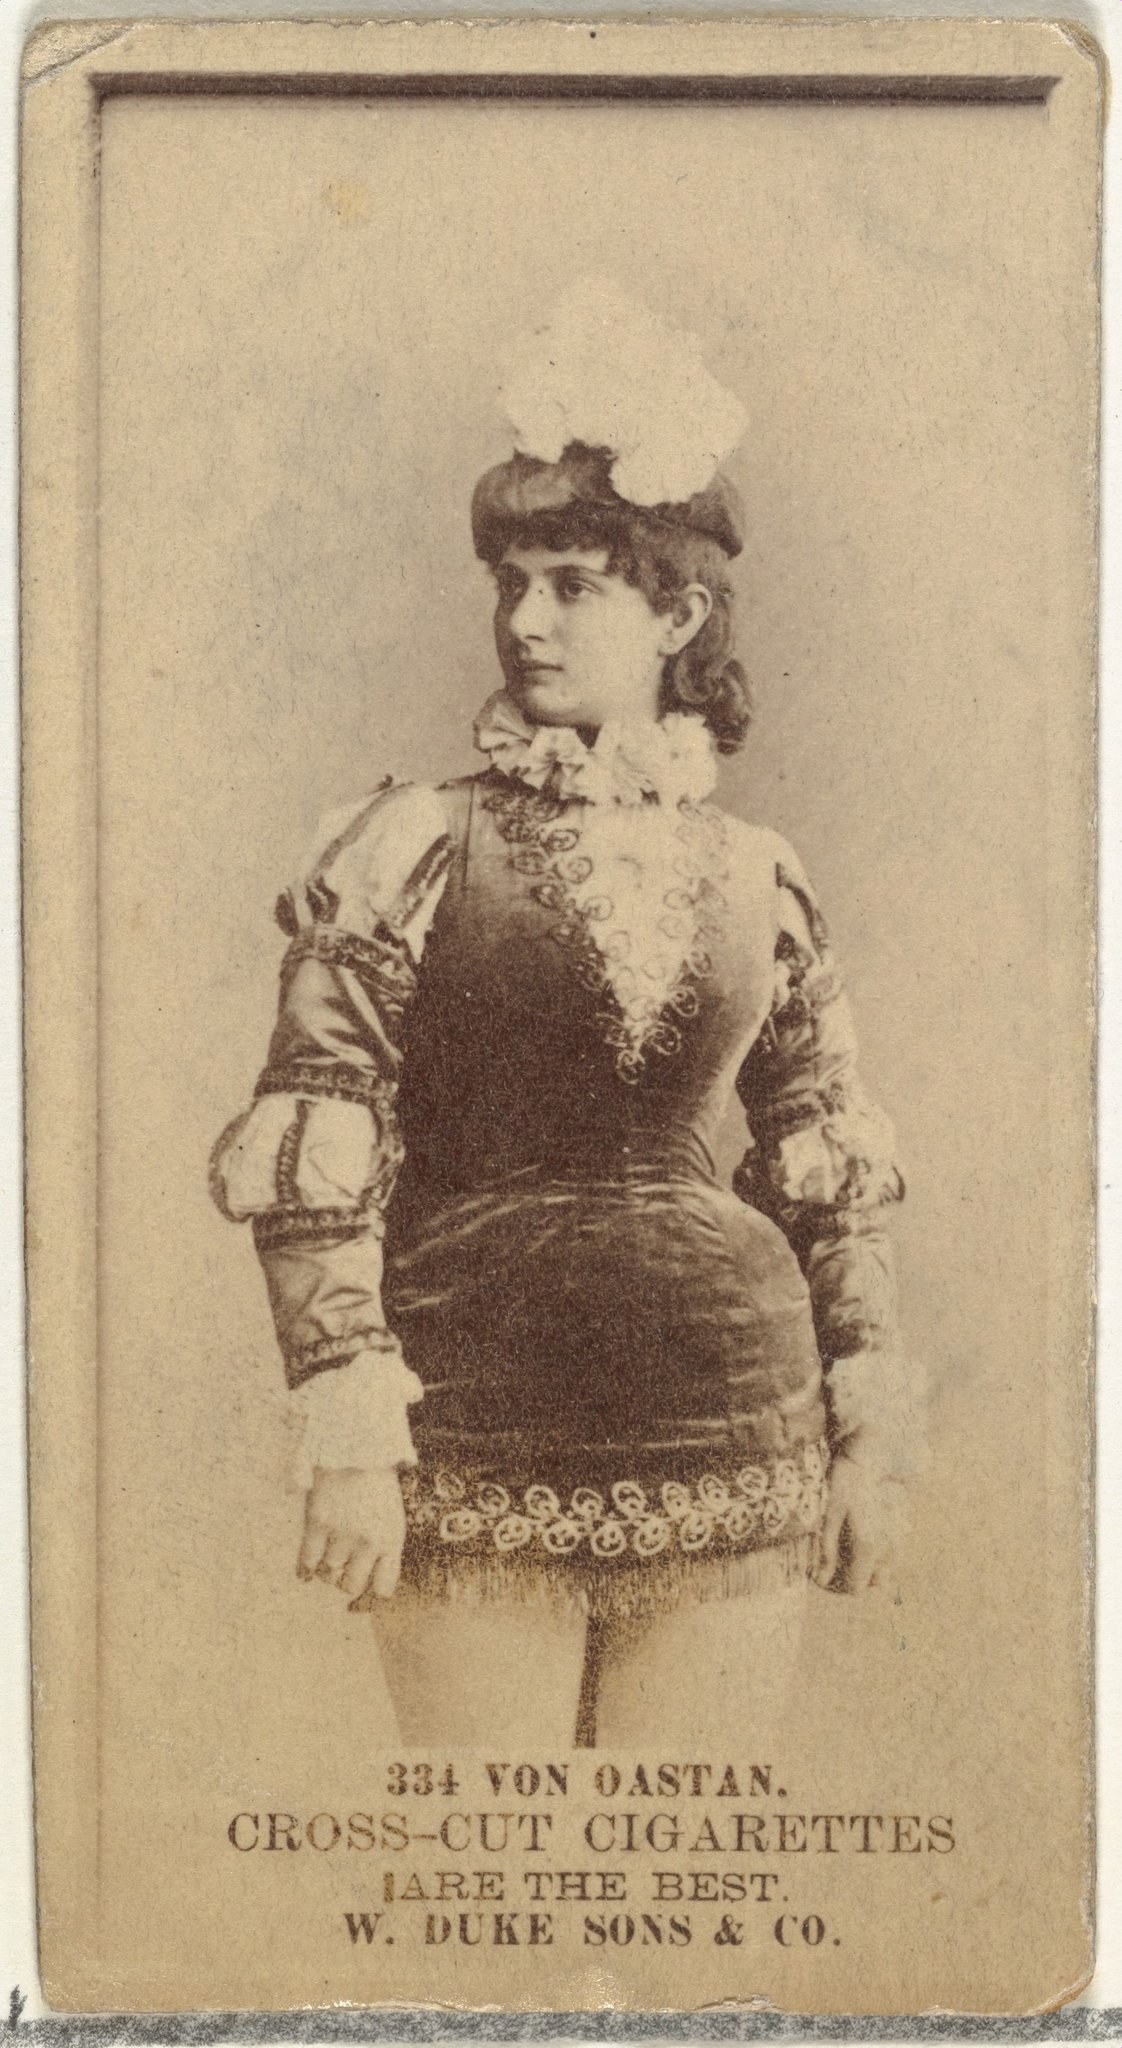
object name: photograph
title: Card Number 334, Von Oastan, from the Actors and Actresses series (N145-3) issued by Duke Sons & Co. to promote Cross Cut Cigarettes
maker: w. duke, sons & co.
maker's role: publisher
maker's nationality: american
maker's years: 1870-1920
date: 1880-1889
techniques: albumen silver print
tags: portraits,women,actresses